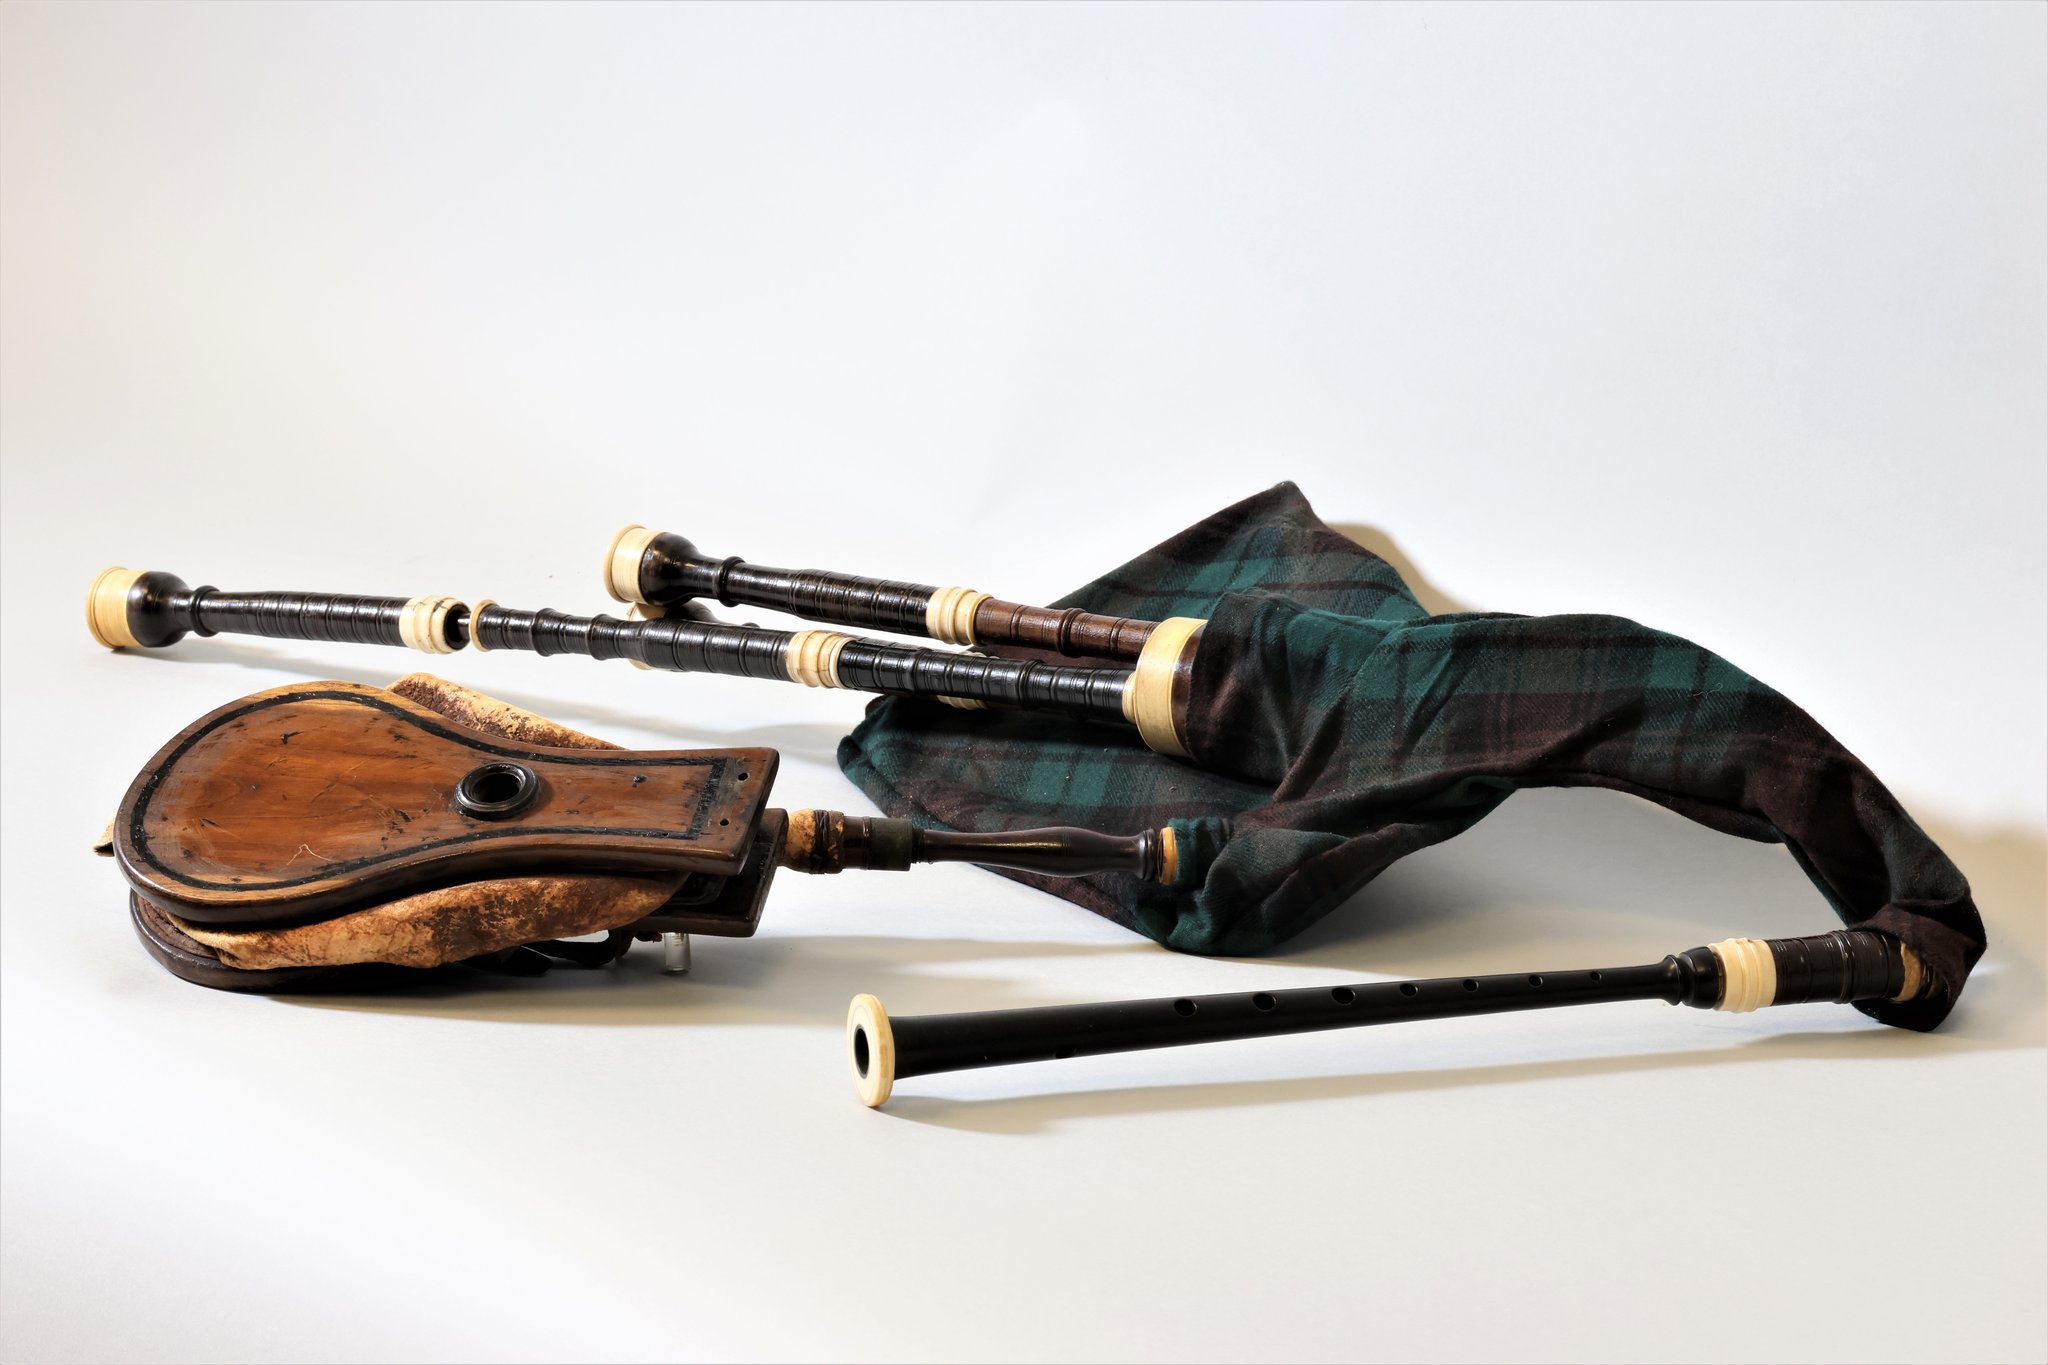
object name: lowland pipe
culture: scottish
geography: scotland